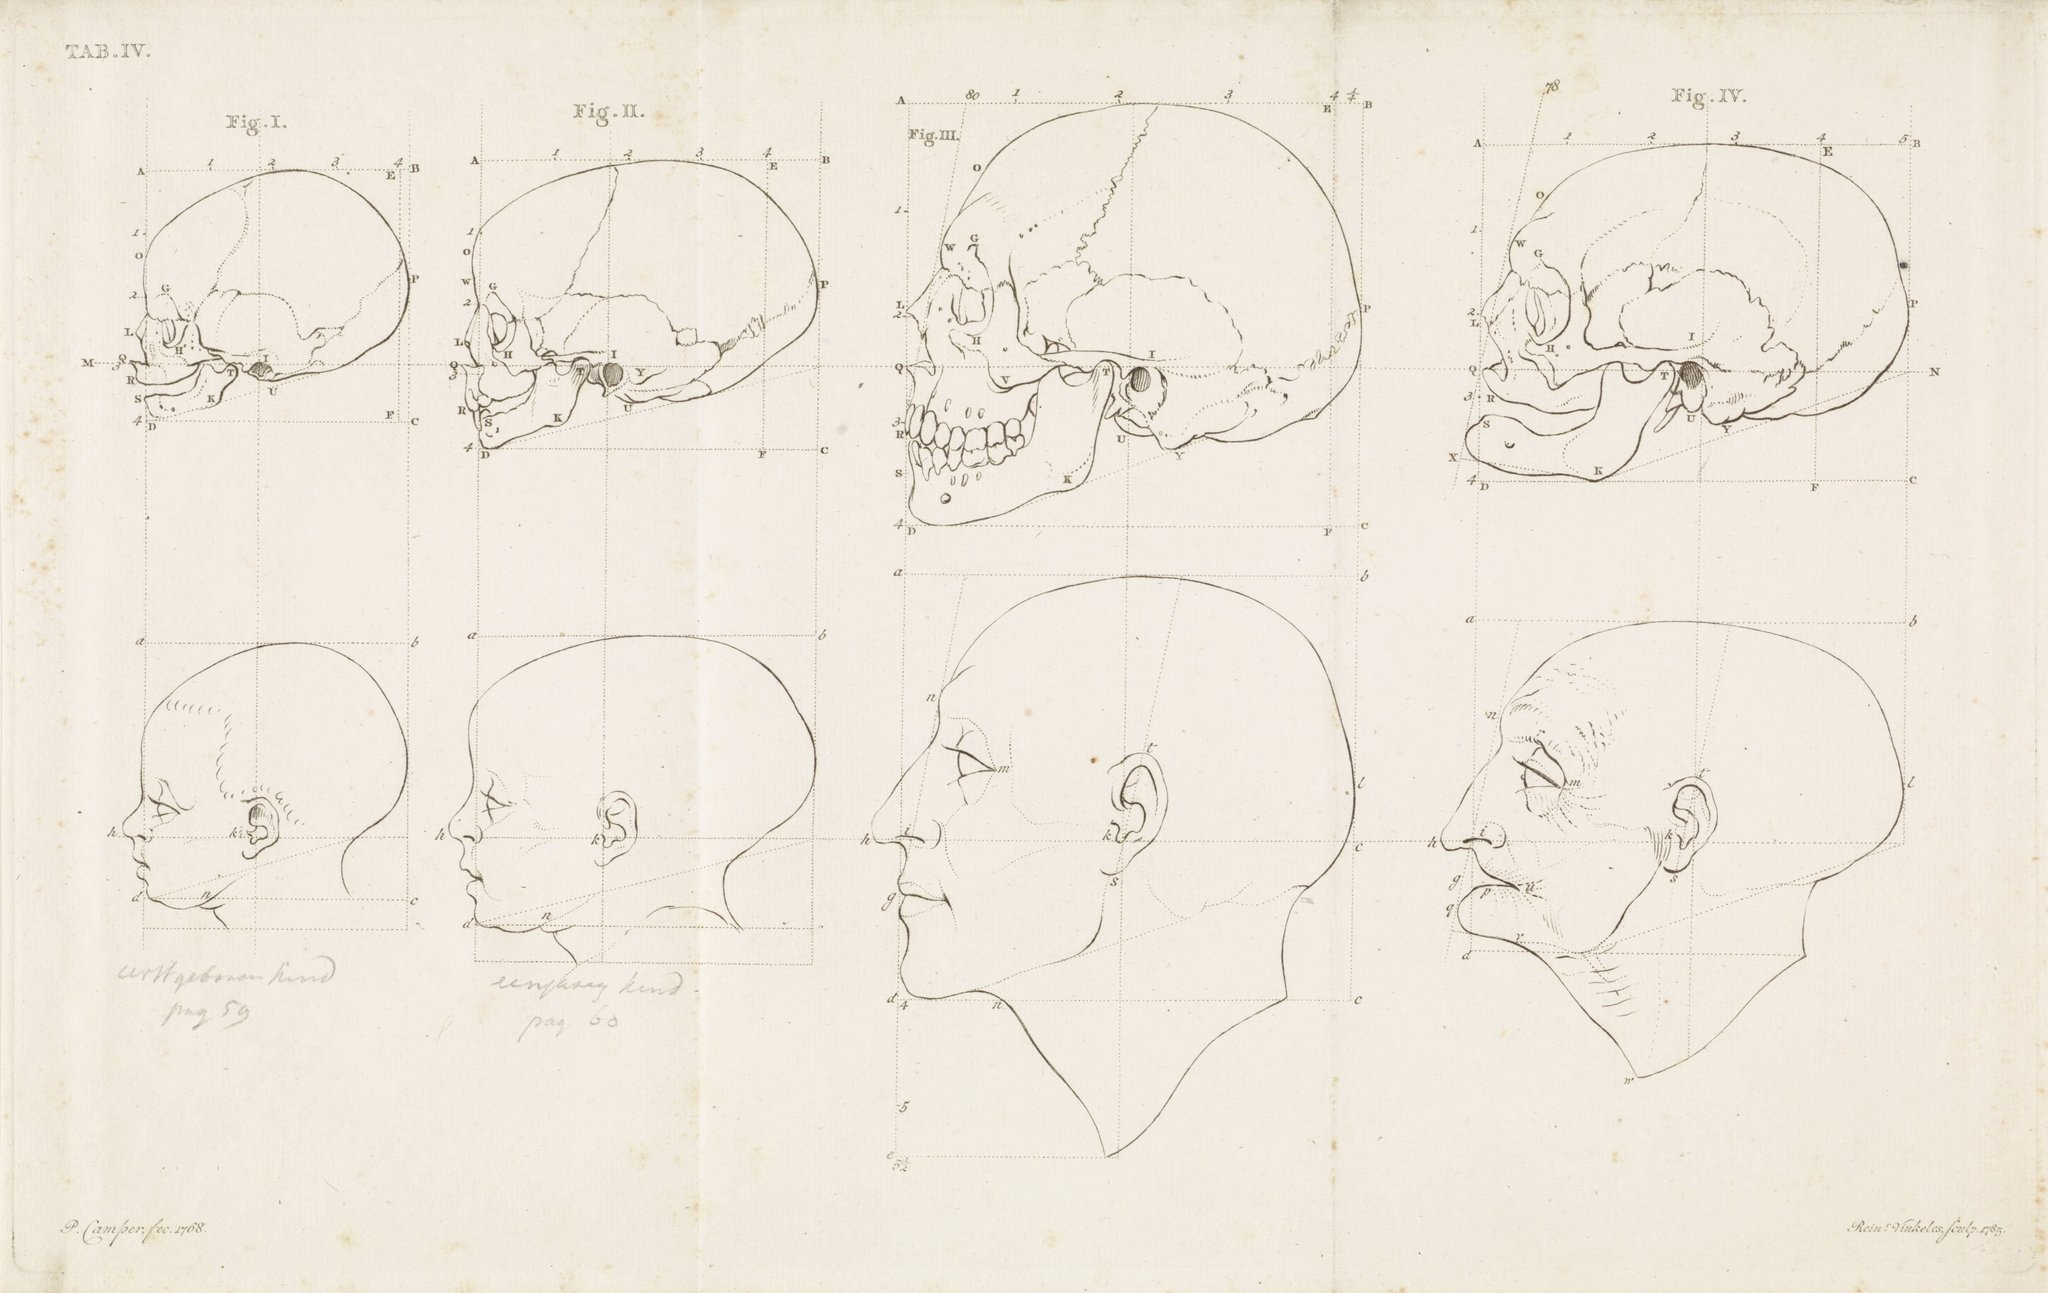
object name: print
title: Studie van een menselijke kop en schedel op verschillende leeftijden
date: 1785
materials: paper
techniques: etching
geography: amsterdam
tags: head (human) (+ sideview, profile)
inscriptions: collector's mark: Lugt 2228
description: Blad met vier studies van een kop en vier van een schedel op verschillende leeftijden.